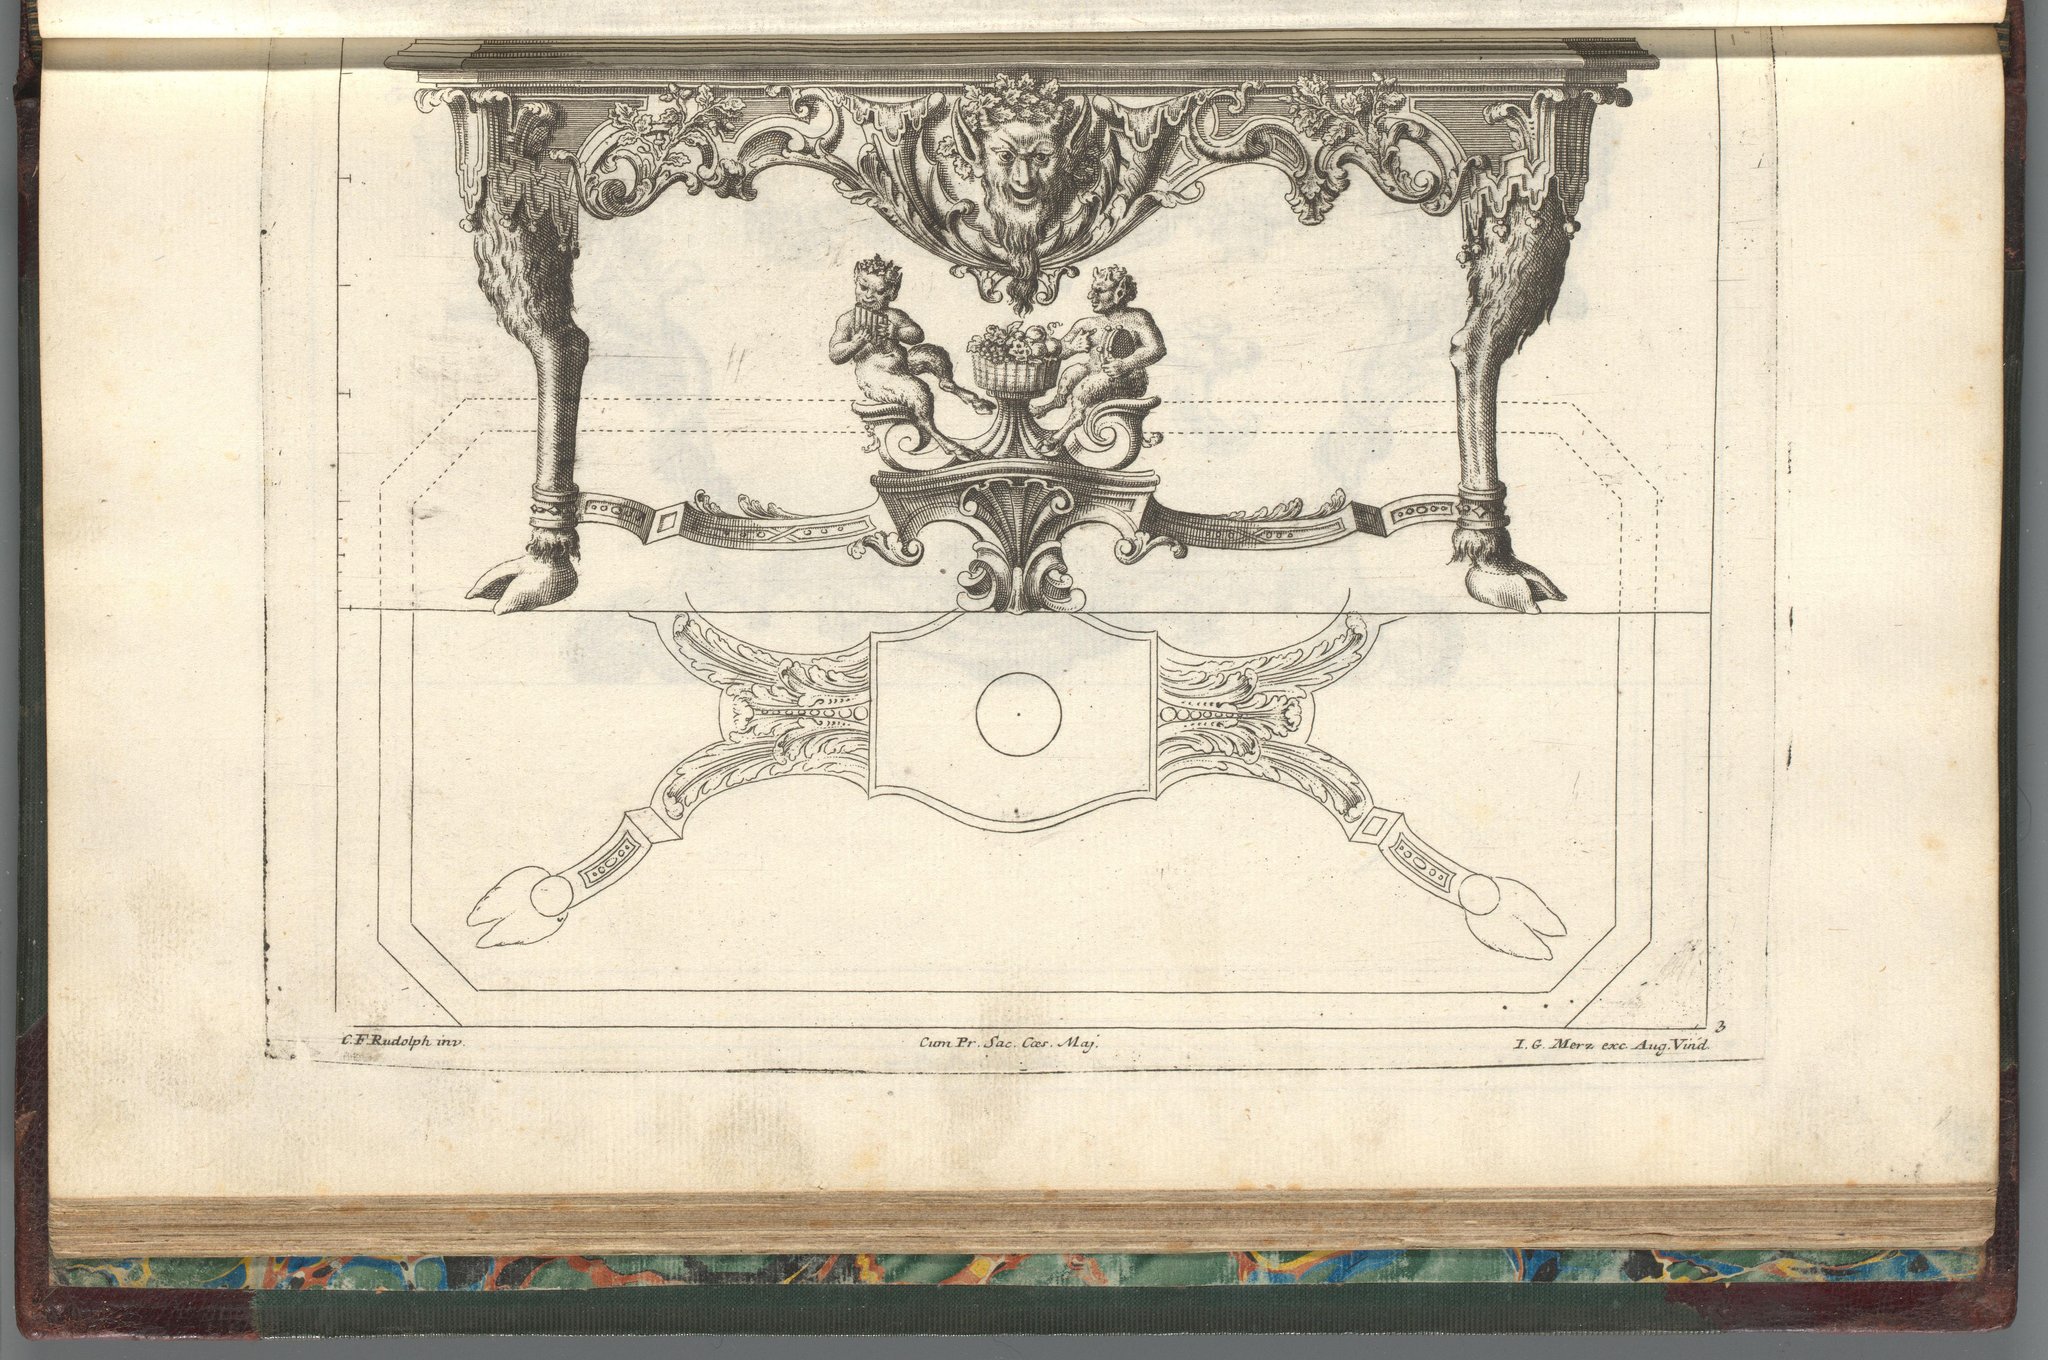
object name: ornament print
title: Ontwerp van een tafel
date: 1704-1762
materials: paper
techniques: etching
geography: augsburg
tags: ornaments ~ art, table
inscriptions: signature: ‘I.G. Merz exc. Aug. Vind.’, number: ‘3’, privilege: ‘Cum Pr. Sac. Cas. Maj.’, signature: ‘C.F. Rudolph inv.’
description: Ontwerp van een tafel met twee saters met daaronder een schematische weergave van het tafelblad. Derde prent uit een serie van zes. Prent maakt deel uit van een album.